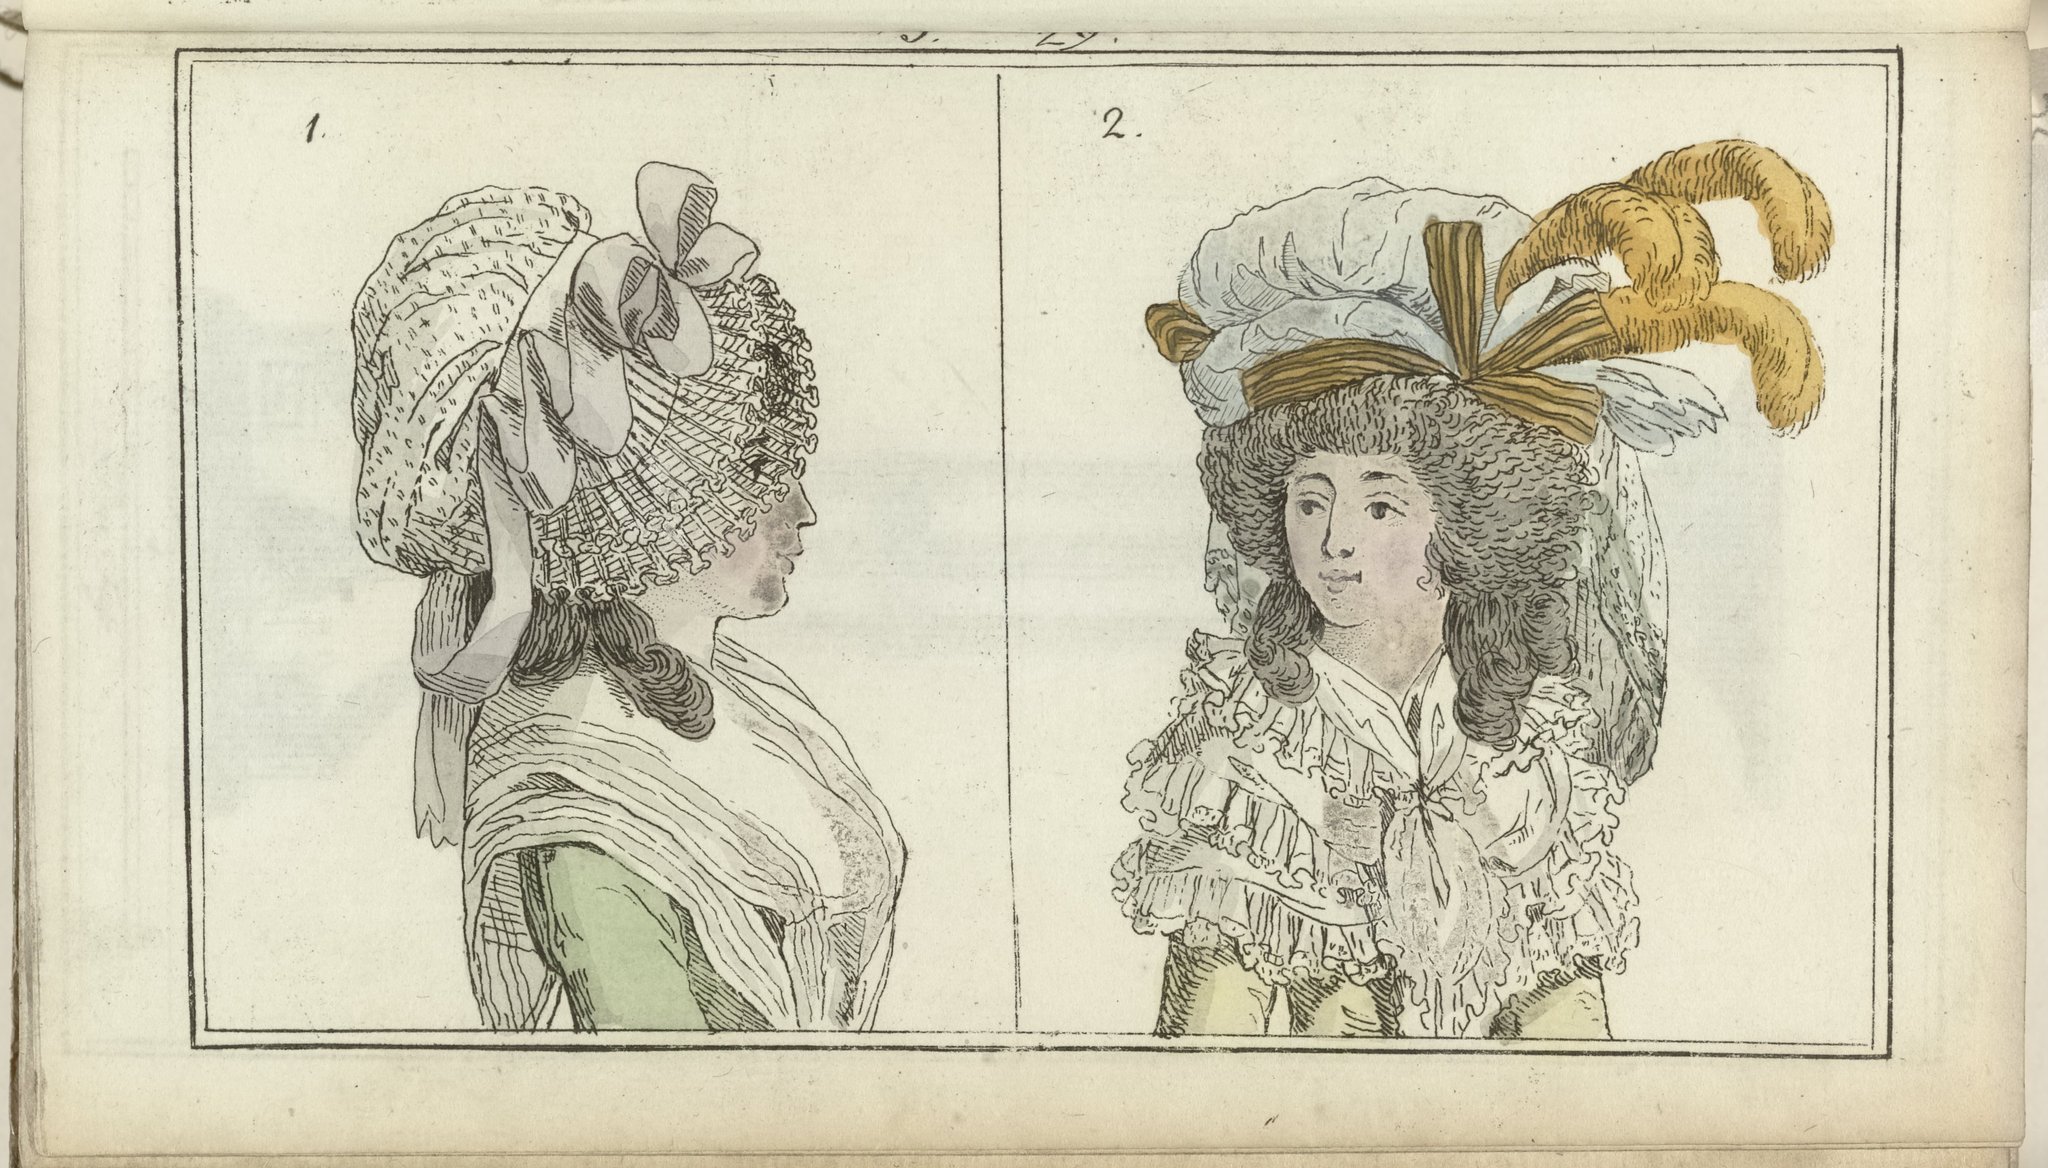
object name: fashion print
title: Journal des Luxus und der Moden 1788, Band III, T.29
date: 1788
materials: paper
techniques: etching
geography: weimar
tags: fashion plates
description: Prent uit het modetijdschrift Journal des Luxus und der Moden, uitgegeven door Friedrich Justin Bertuch en Georg Melchior Kraus, Weimar, 1786-1826.